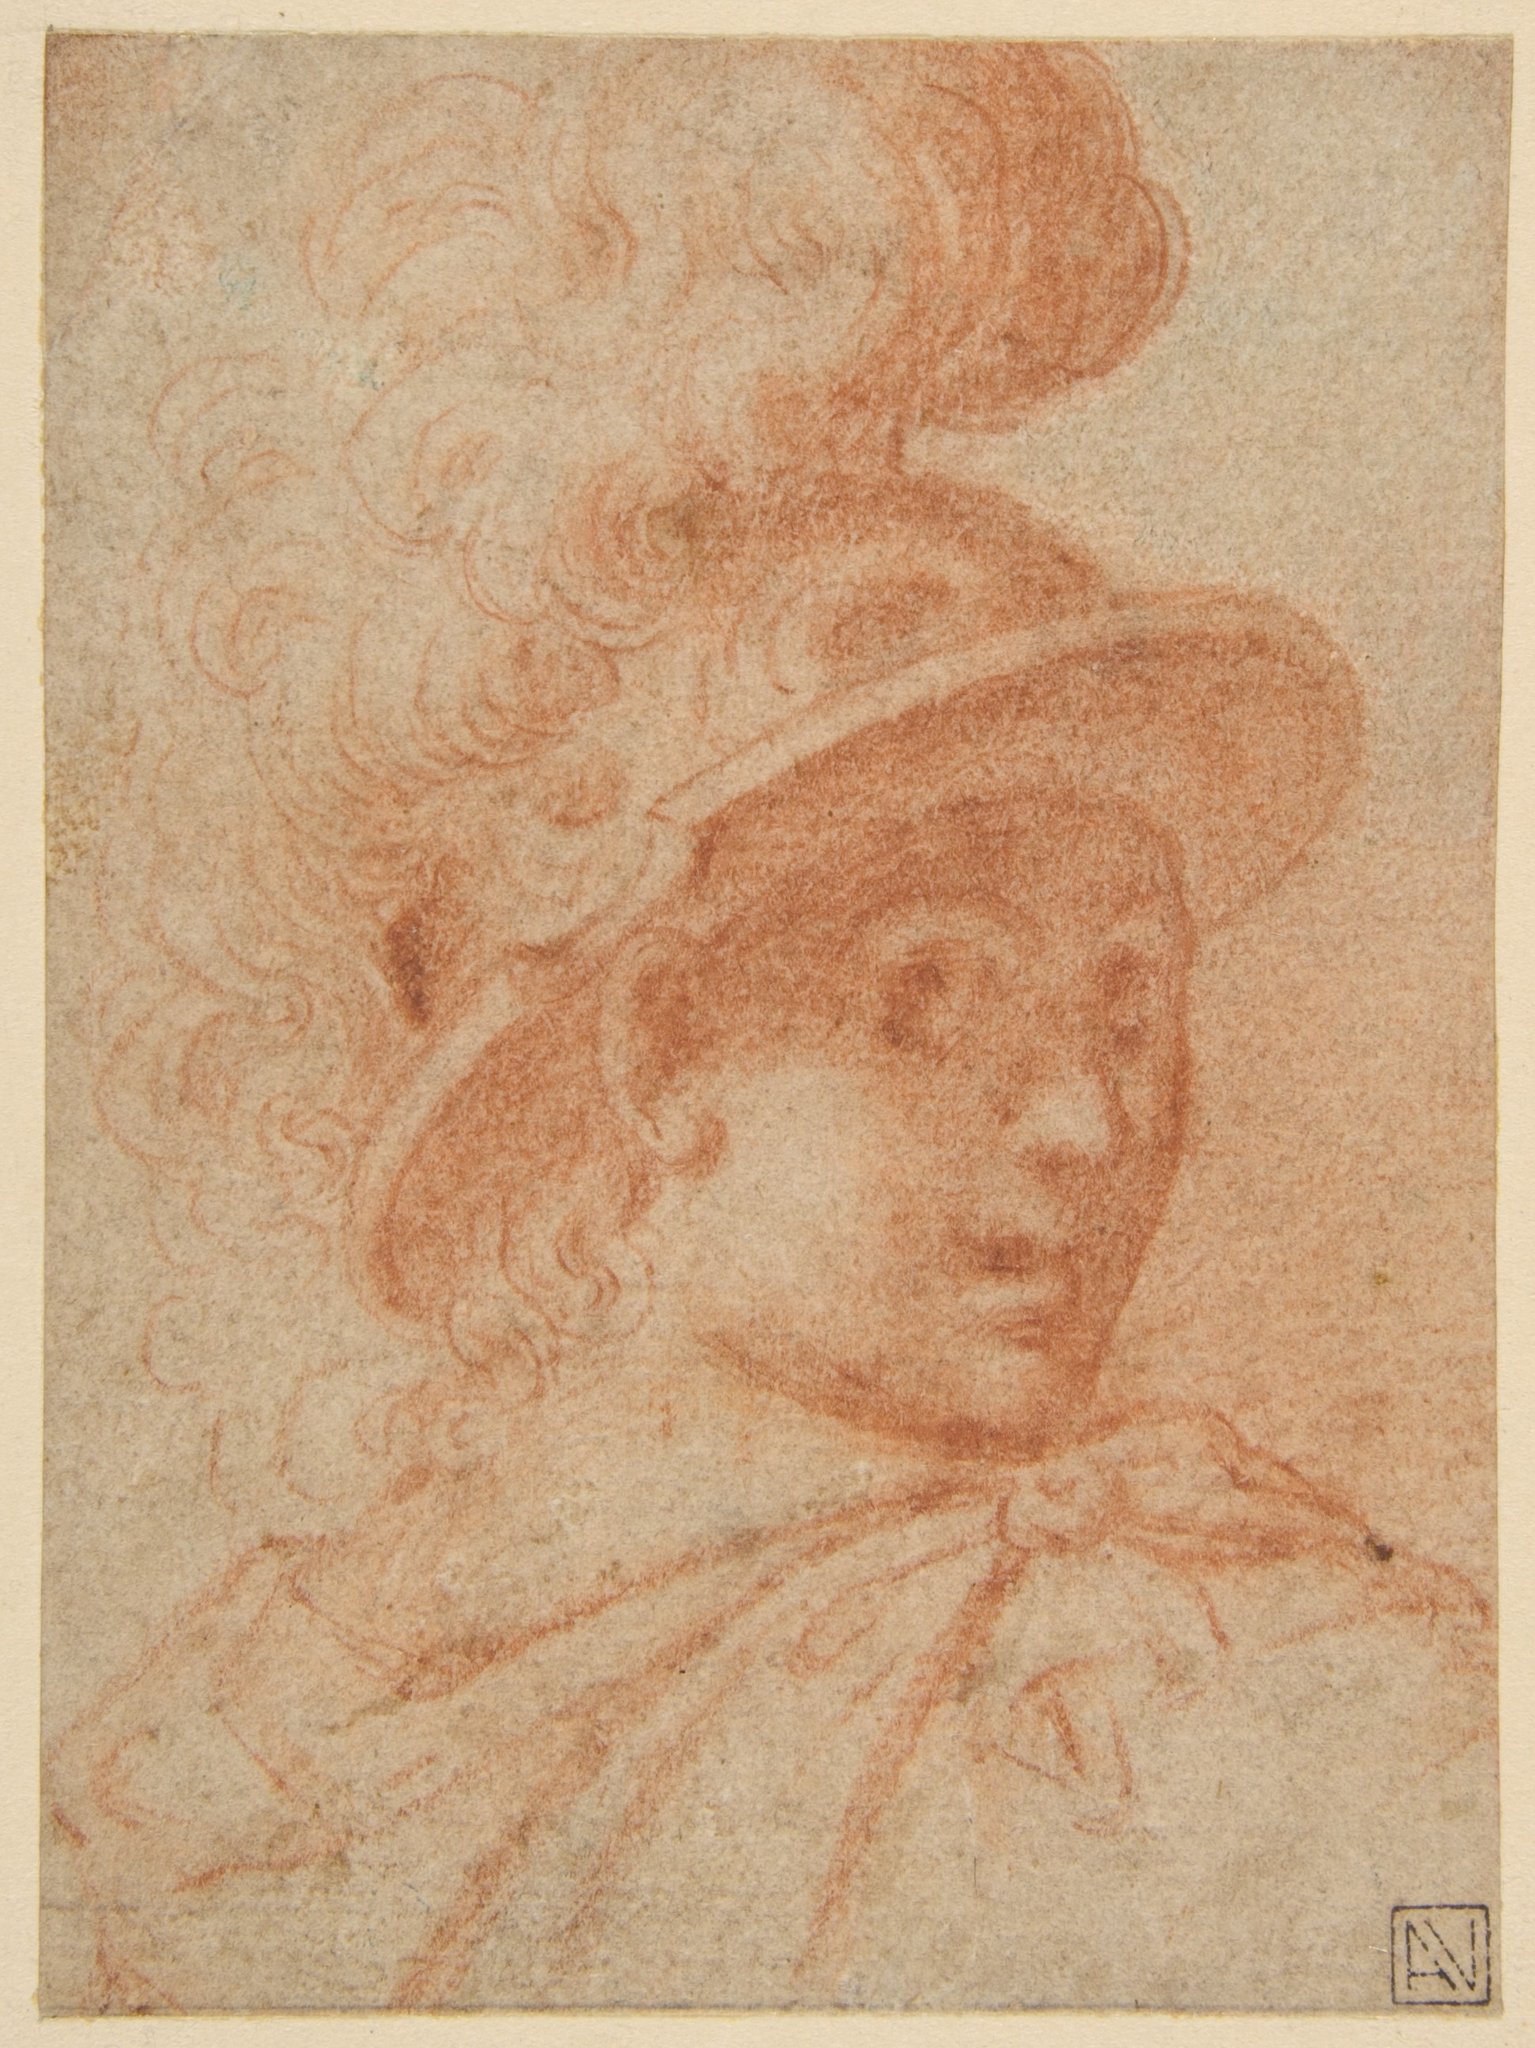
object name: drawing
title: Bust of a Warrior Wearing a Plumed Helmet, Looking Toward Spectator Over His Right Shoulder (recto); Sketch of a Leg (verso)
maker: camillo procaccini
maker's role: artist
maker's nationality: italian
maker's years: 1555-1629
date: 1605-1609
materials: chalk, paper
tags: helmets,men,portraits